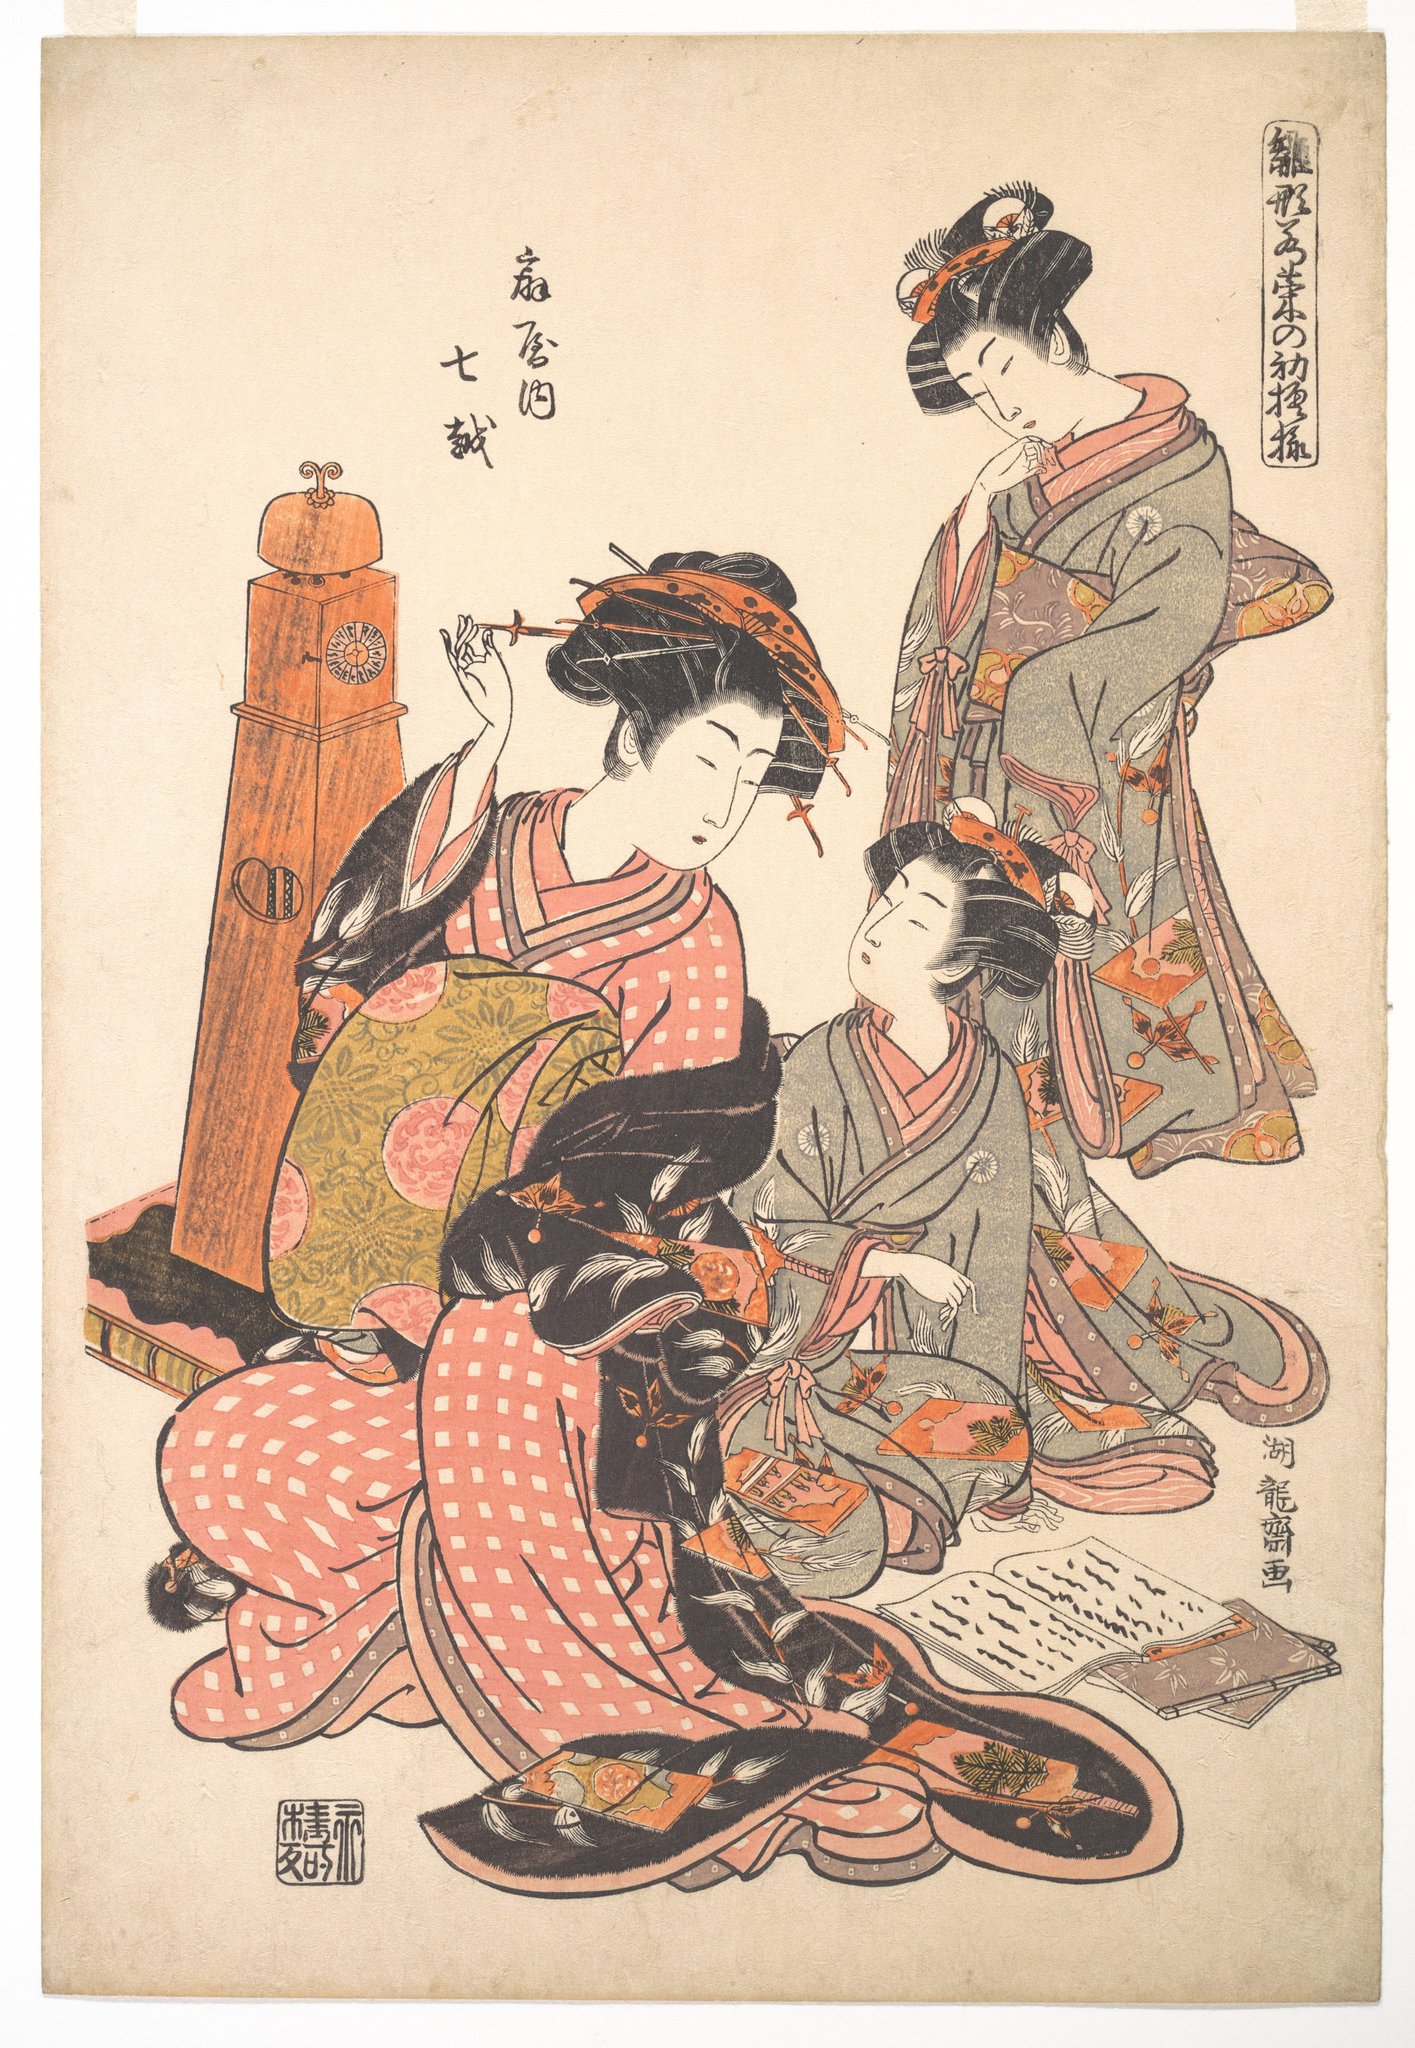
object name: woodblock print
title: The Courtesan Nanakoshi of the Ōgiya Brothel, from the series “A Pat-tern Book of the Year’s First Designs, Fresh as Spring Herbs” (“Hinagata wakana no hatsu moyō”)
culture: japanese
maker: isoda koryūsai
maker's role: artist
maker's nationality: japanese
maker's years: 1735-1790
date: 1777-1778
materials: ink, paper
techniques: woodblock print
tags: women,clocks